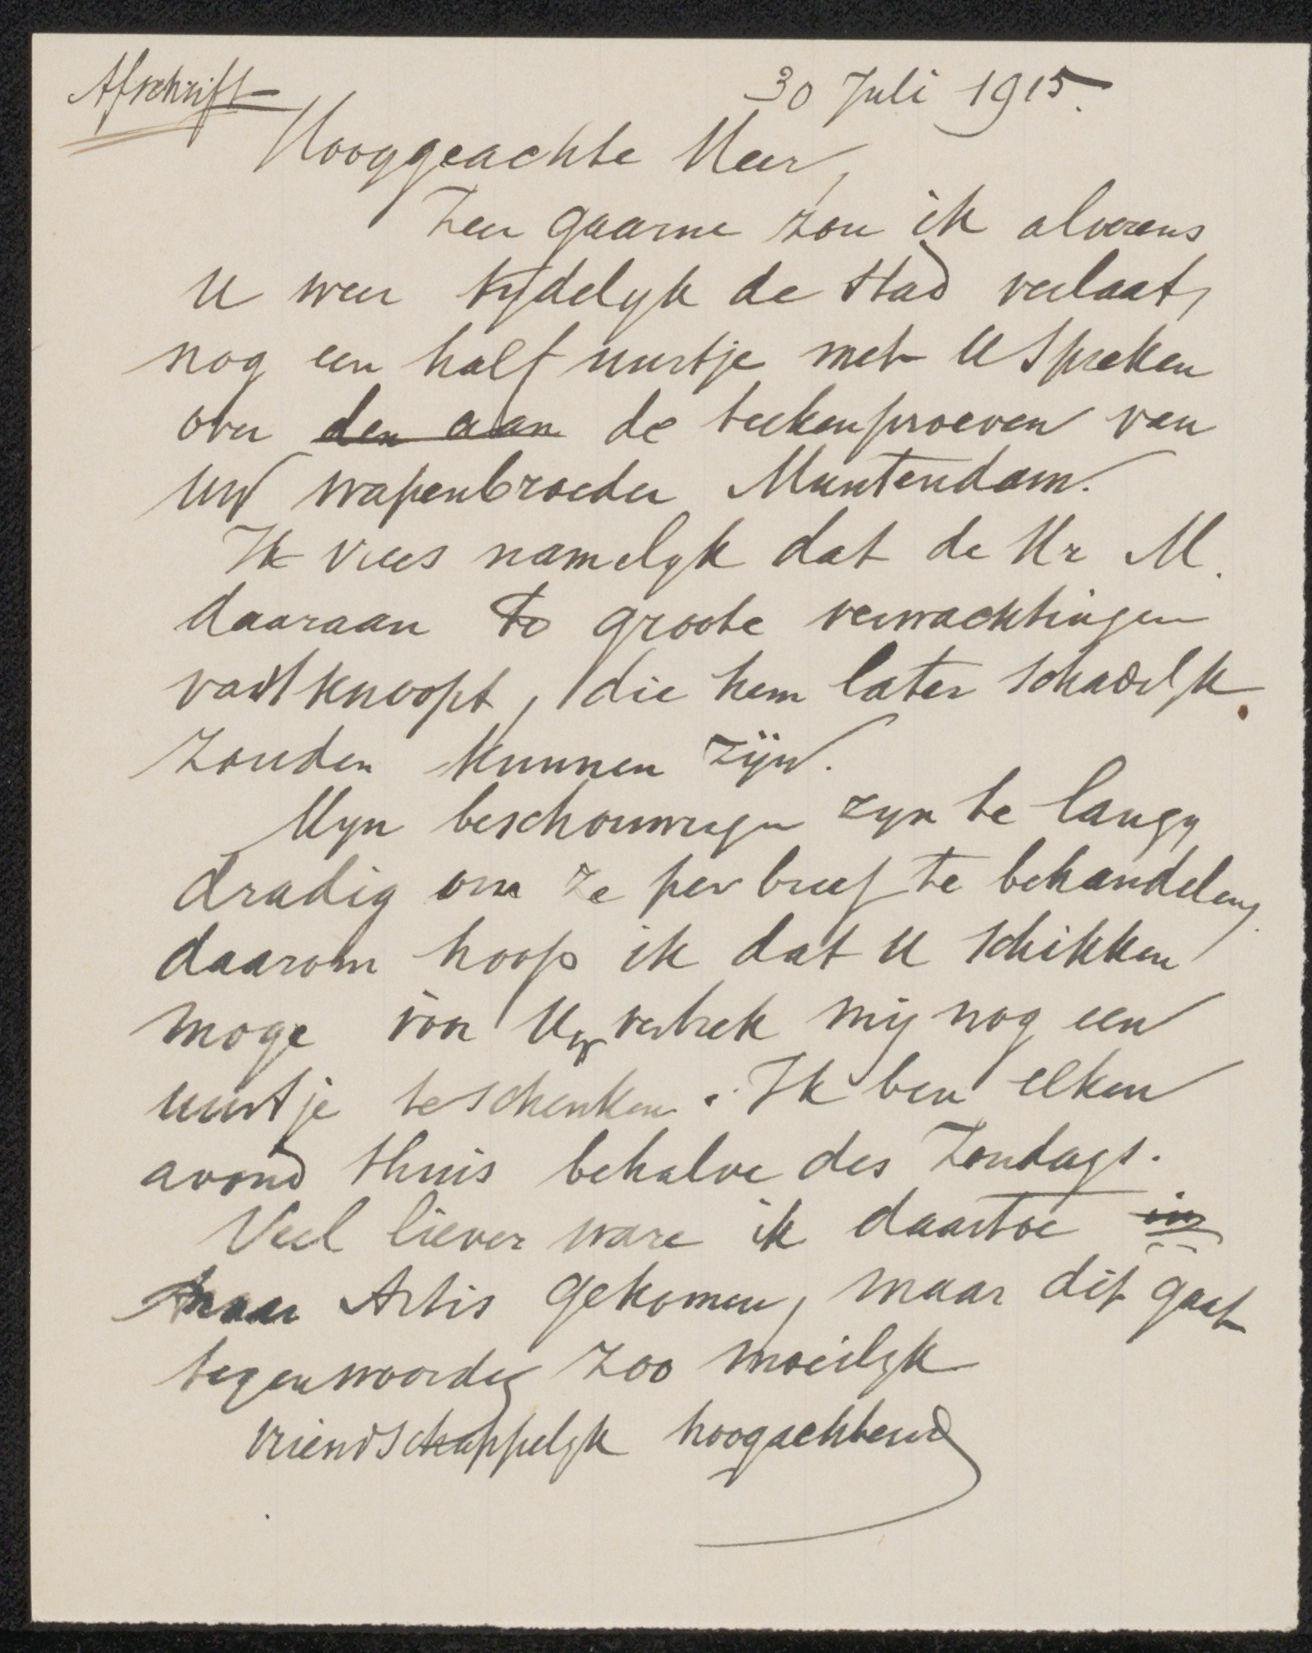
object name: letter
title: Brief aan anoniem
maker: august allebé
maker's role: draughtsman, print maker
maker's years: 1838-1927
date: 1915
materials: ink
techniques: pen, writing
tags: arnhem, drawing